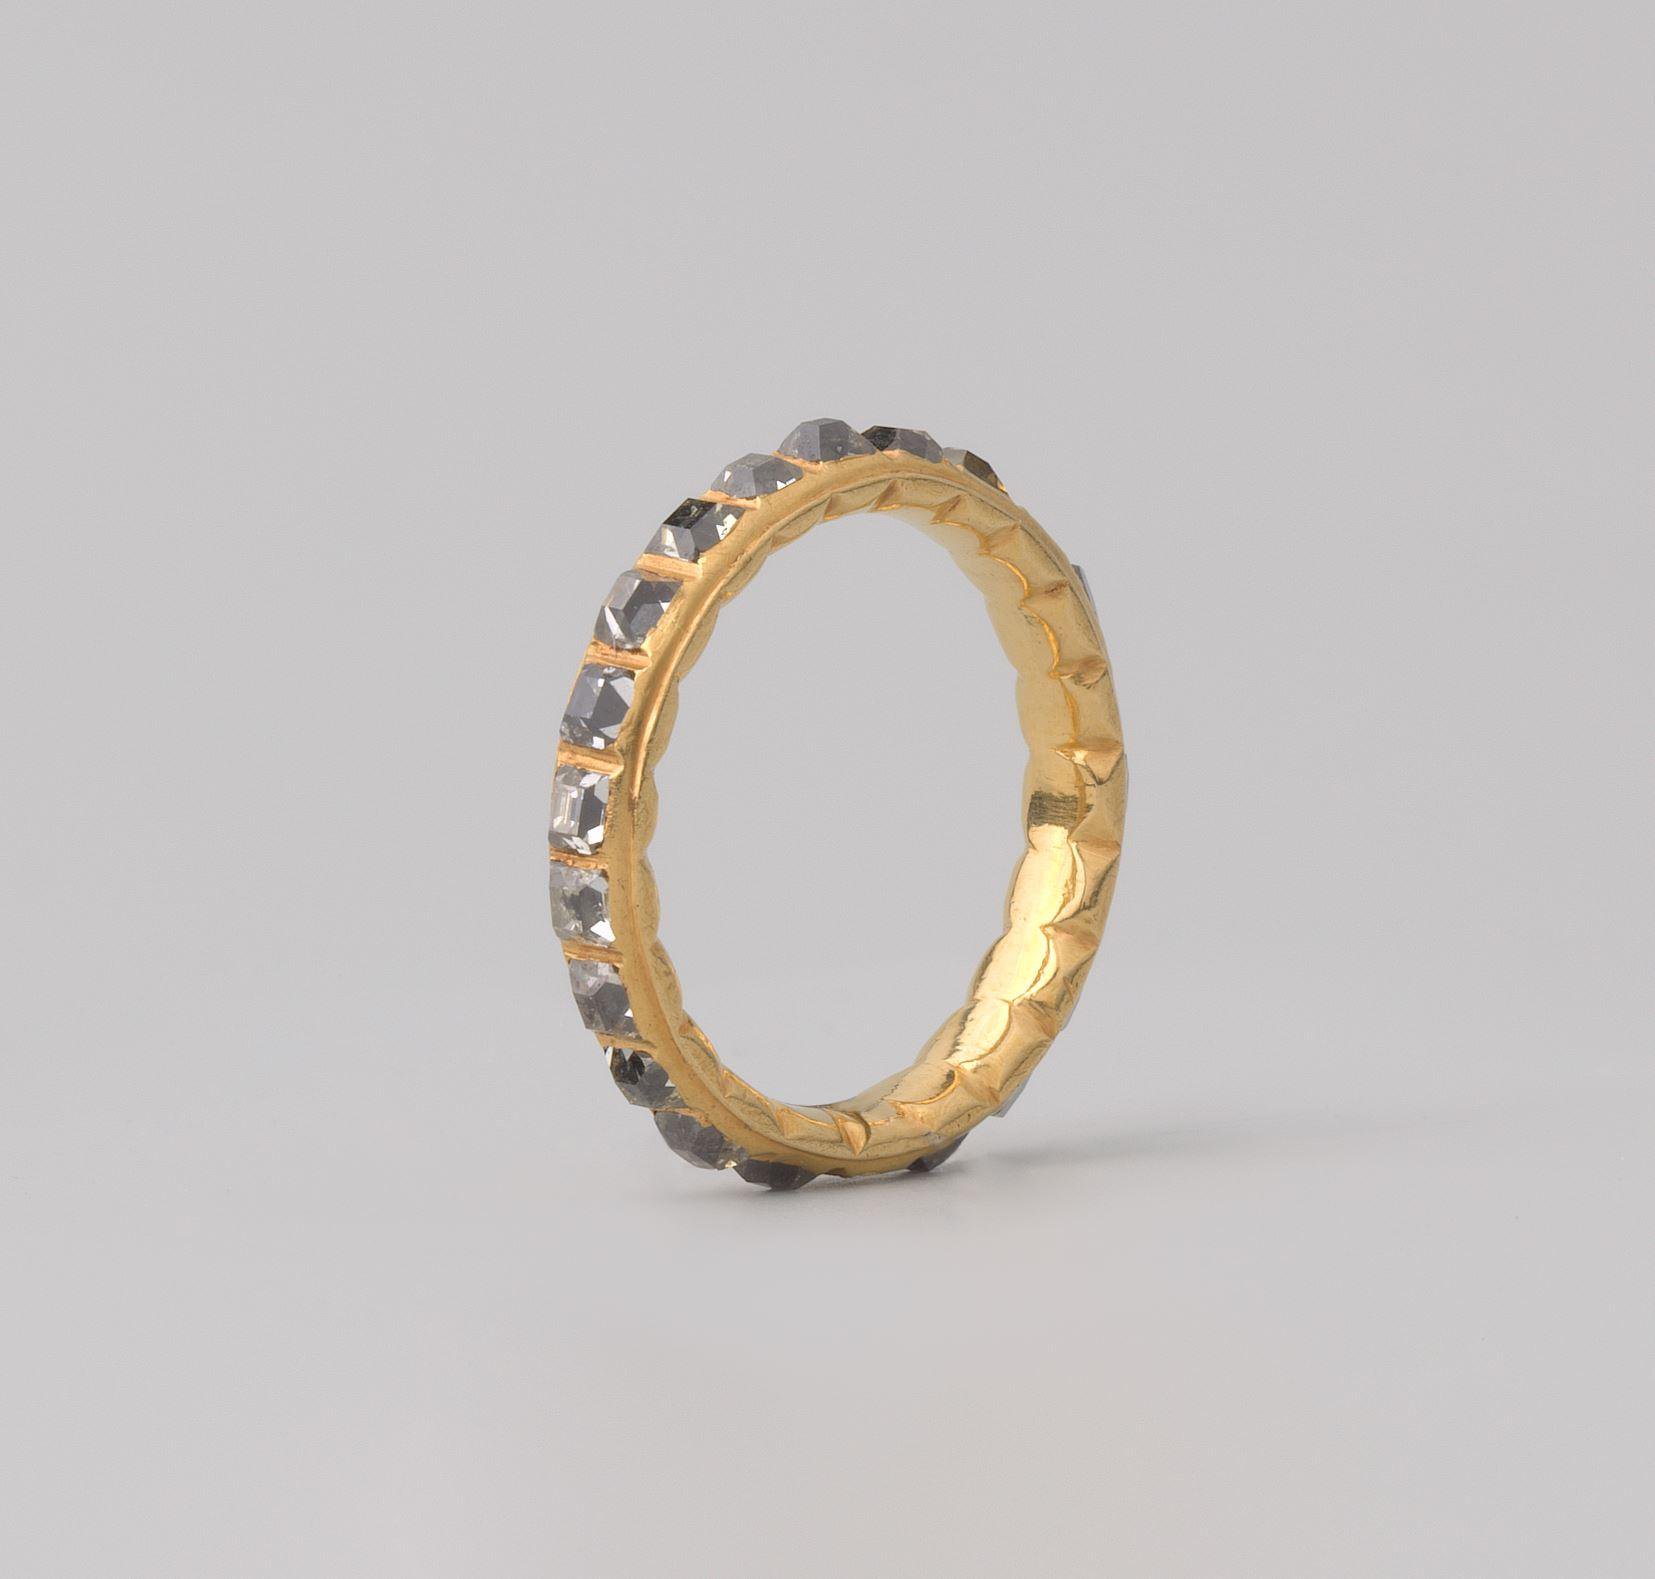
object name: ring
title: Ring with Table-cut Diamonds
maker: Anonymous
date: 1620-1650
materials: diamond, gold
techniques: casting, grinding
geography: northern netherlands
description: This special ring was found by an amateur archaeologist with a metal detector in a meadow in the province of Noord-Holland. Until now, this type of ring was known only from 17th-century paintings, including Rembrandt’s 1634 portrait of Oopjen Coppit. It may have been an engagement ring, and was set with table-cut diamonds all around the band, three of which have been lost.